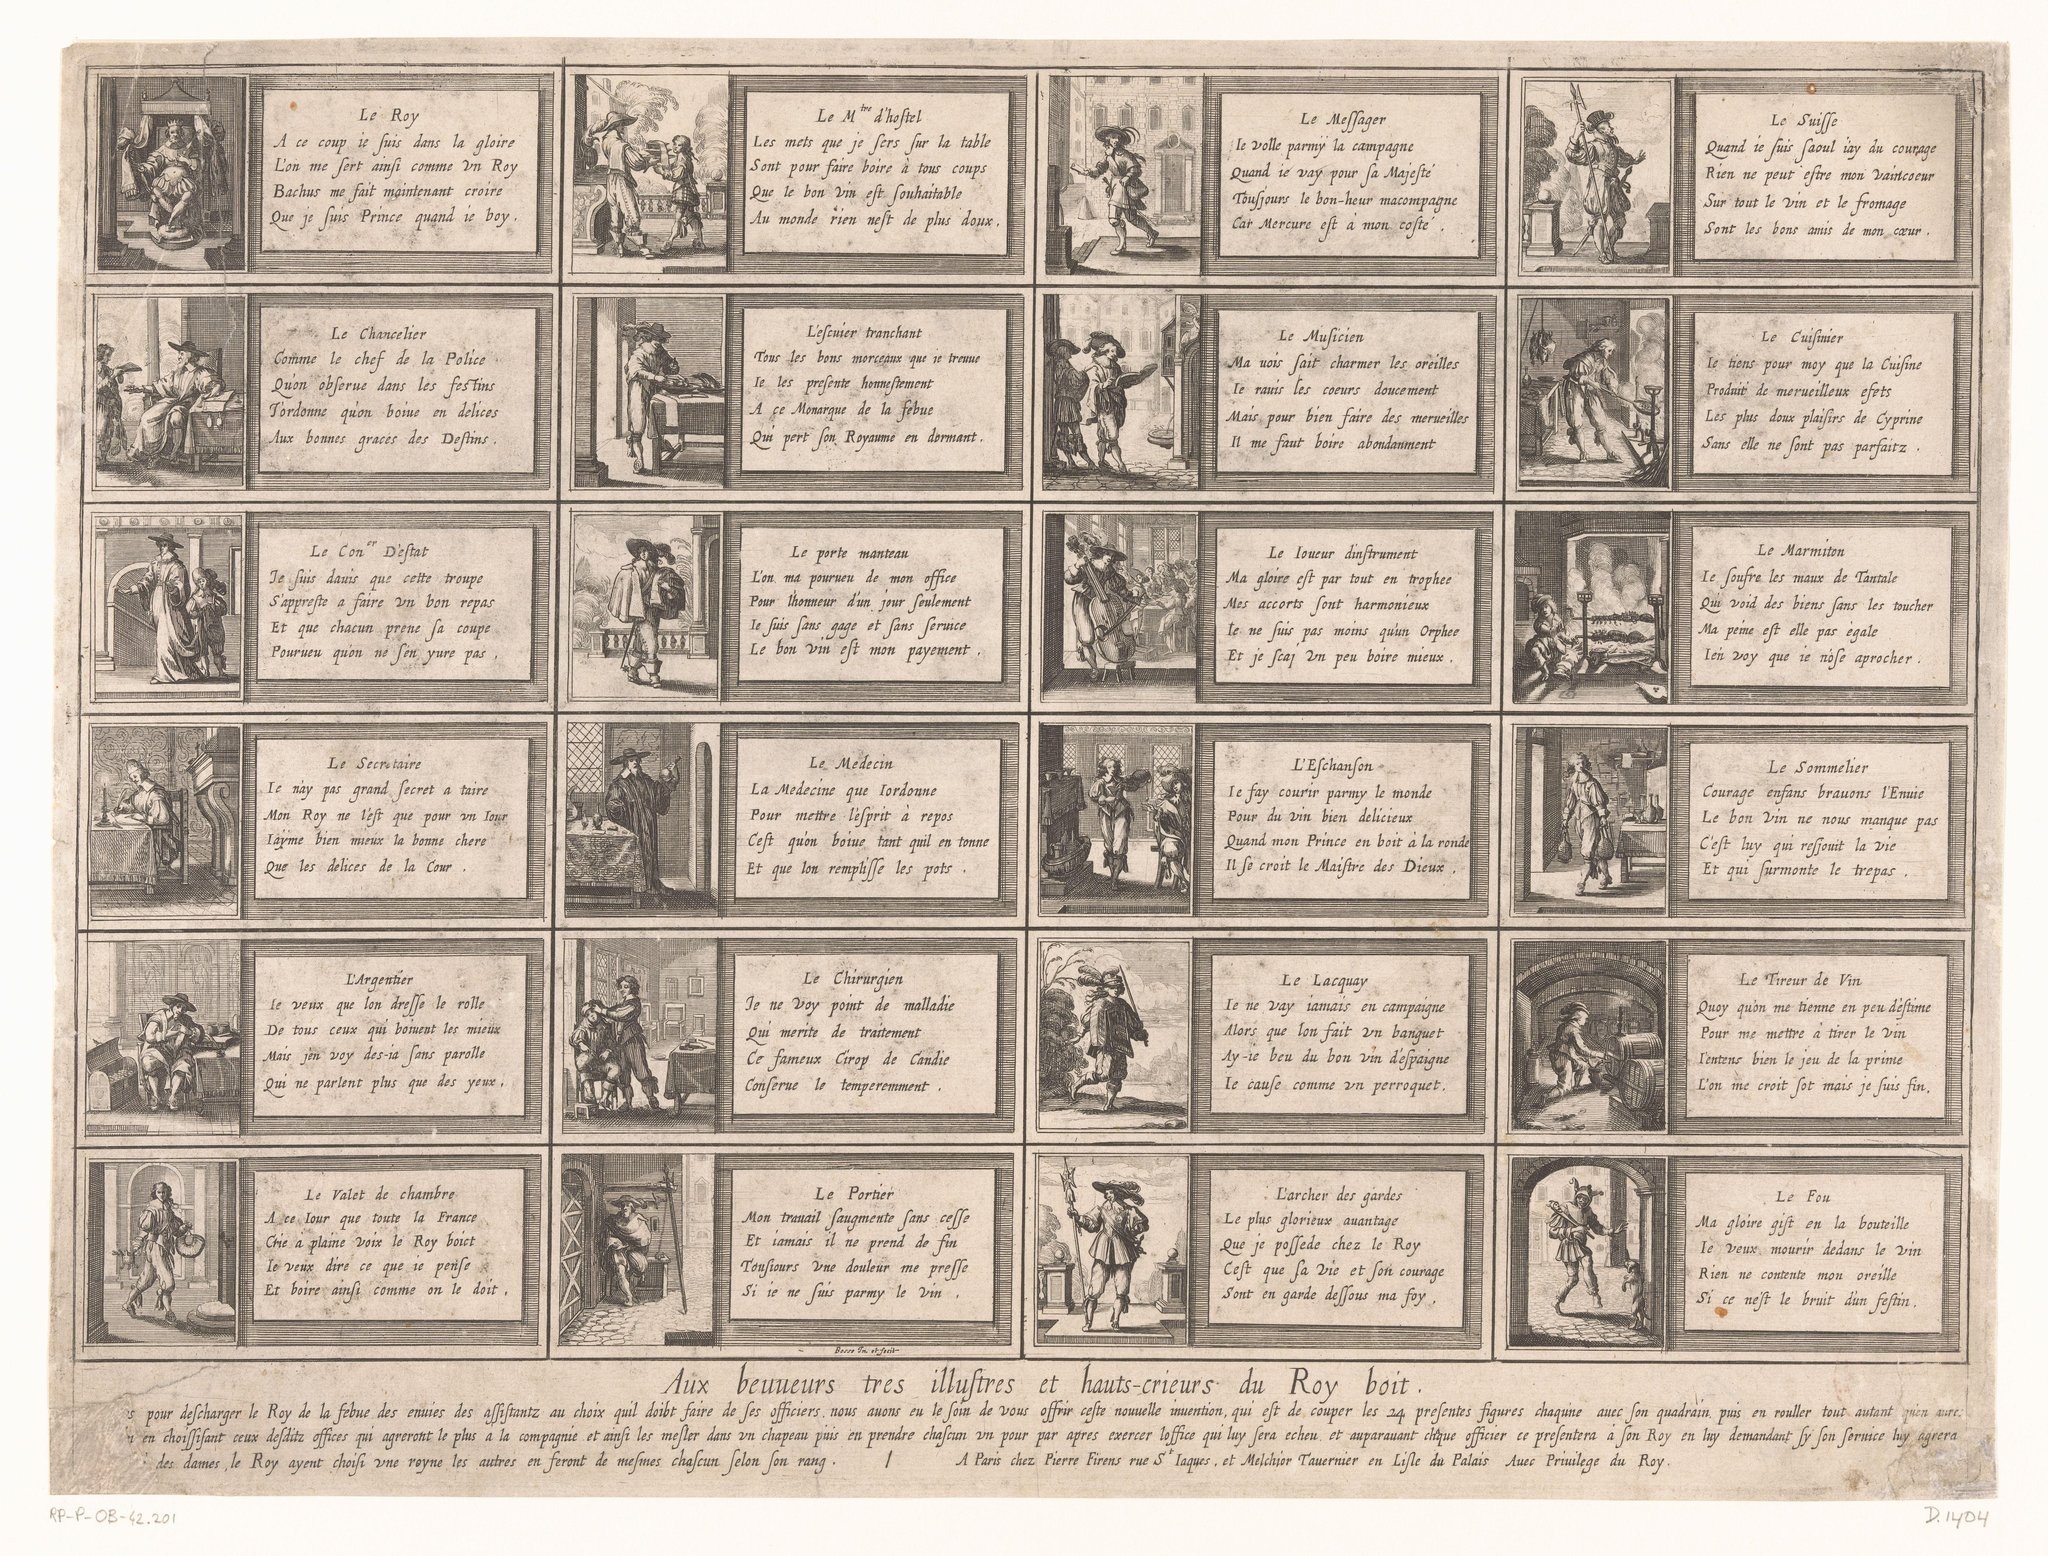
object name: print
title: Vierentwintig afbeeldingen van een koning en zijn hofhouding met tekst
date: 1629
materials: paper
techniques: engraving, etching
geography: paris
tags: family of a ruler, and court, daily life at court, king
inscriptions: collector's mark: Lugt 240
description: Deze vierentwintig afbeeldingen betreffen kaartjes voor een rollenspel dat op Driekoningen werd gespeeld, waarbij alle afbeeldingen met tekst werden uitgeknipt en in een hoed werden gestopt. Ieder die een kaartje trok, zou die dag de afgebeelde rol toebedeeld krijgen.